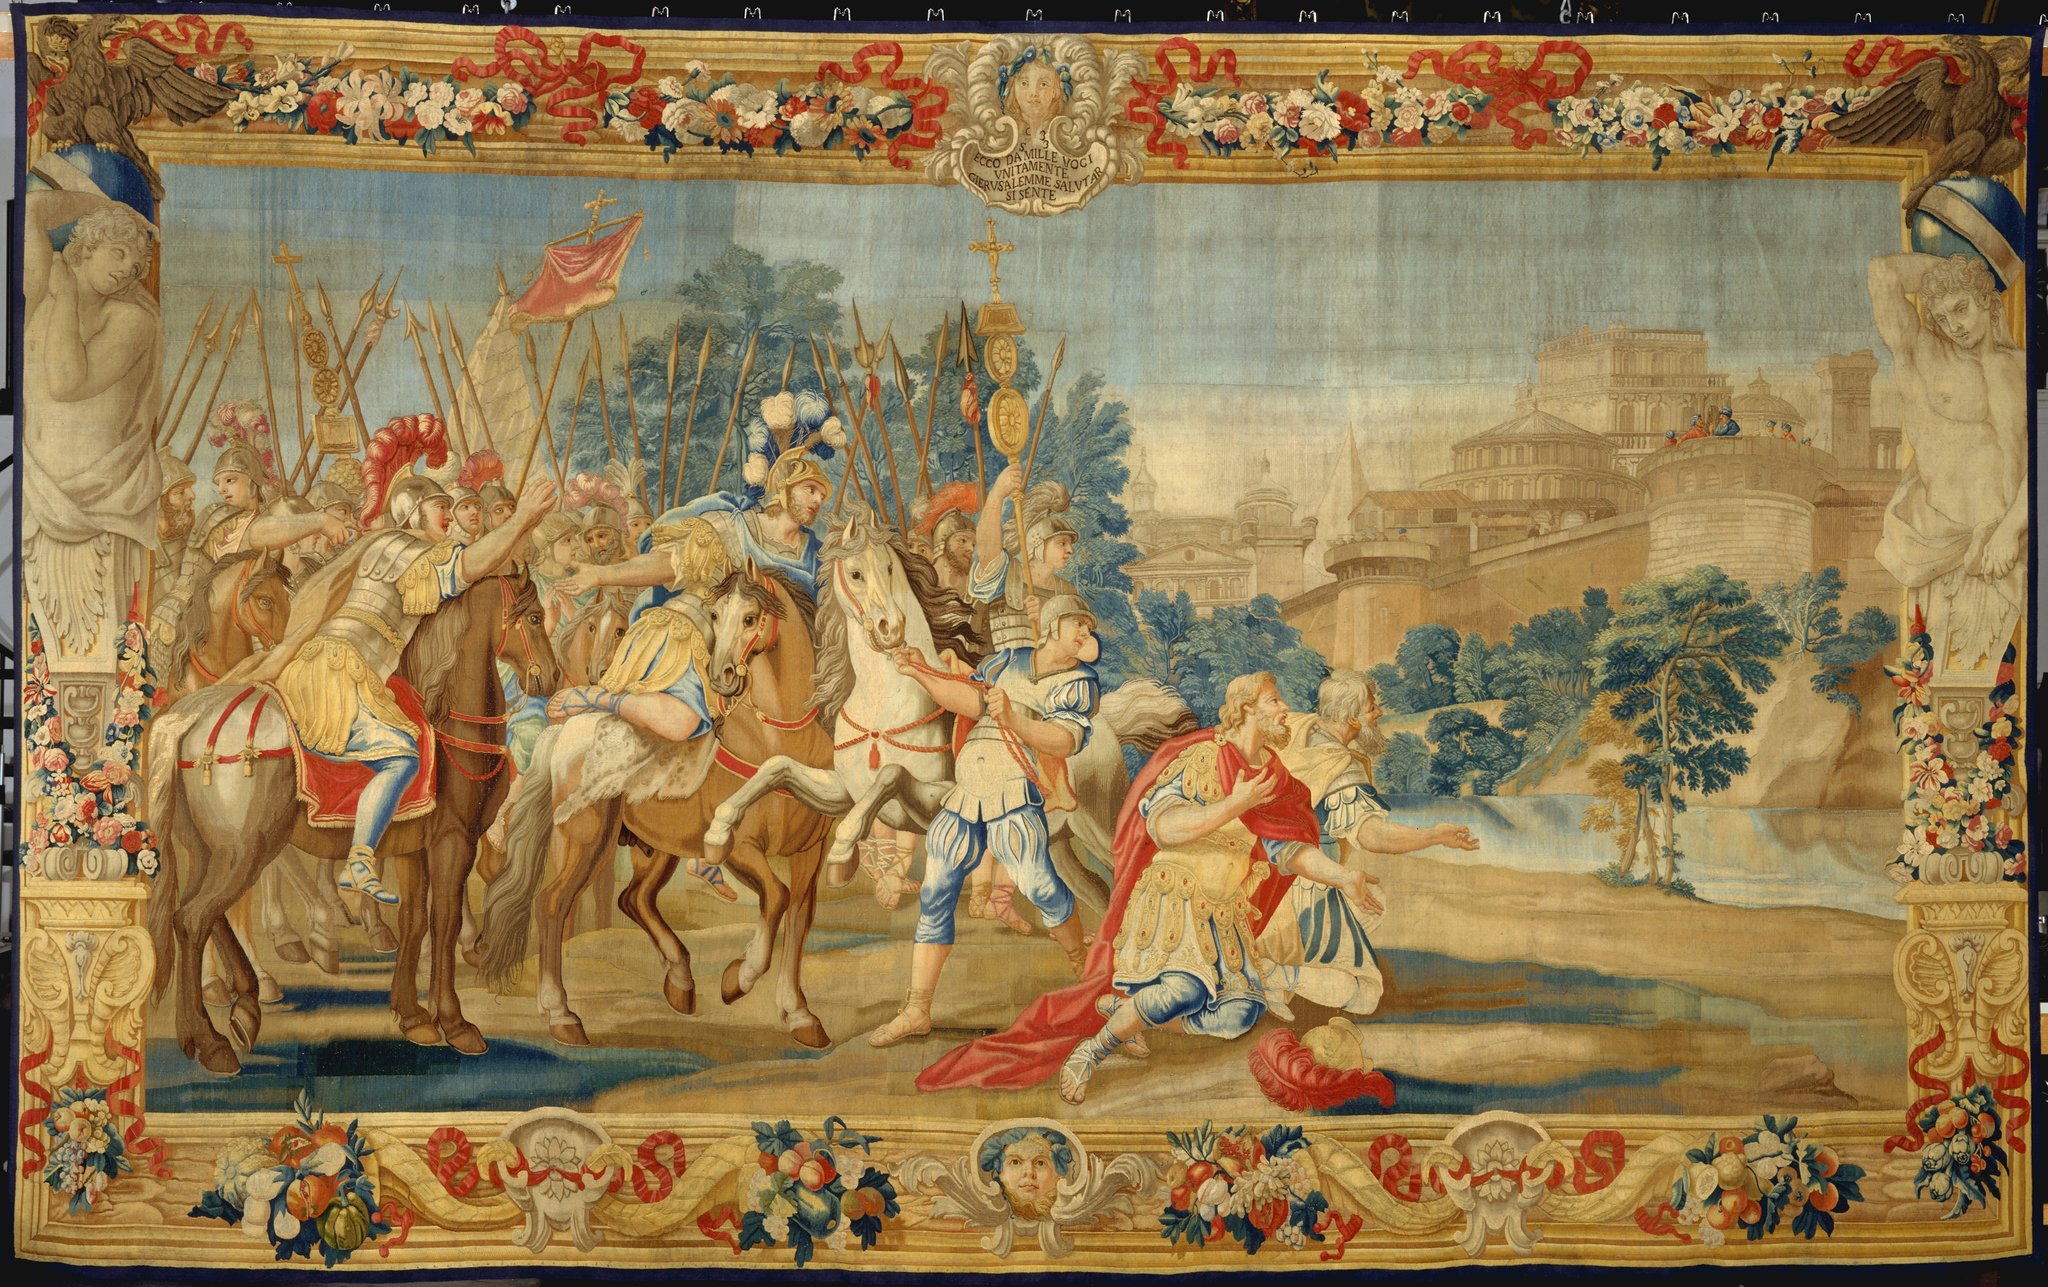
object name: tapestry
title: The Crusaders Reach Jerusalem (from a set of Scenes from Gerusalemme Liberata)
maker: domenico paradisi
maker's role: designer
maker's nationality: italian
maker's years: 1689-1721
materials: silk, wool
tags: buildings,soldiers,horses